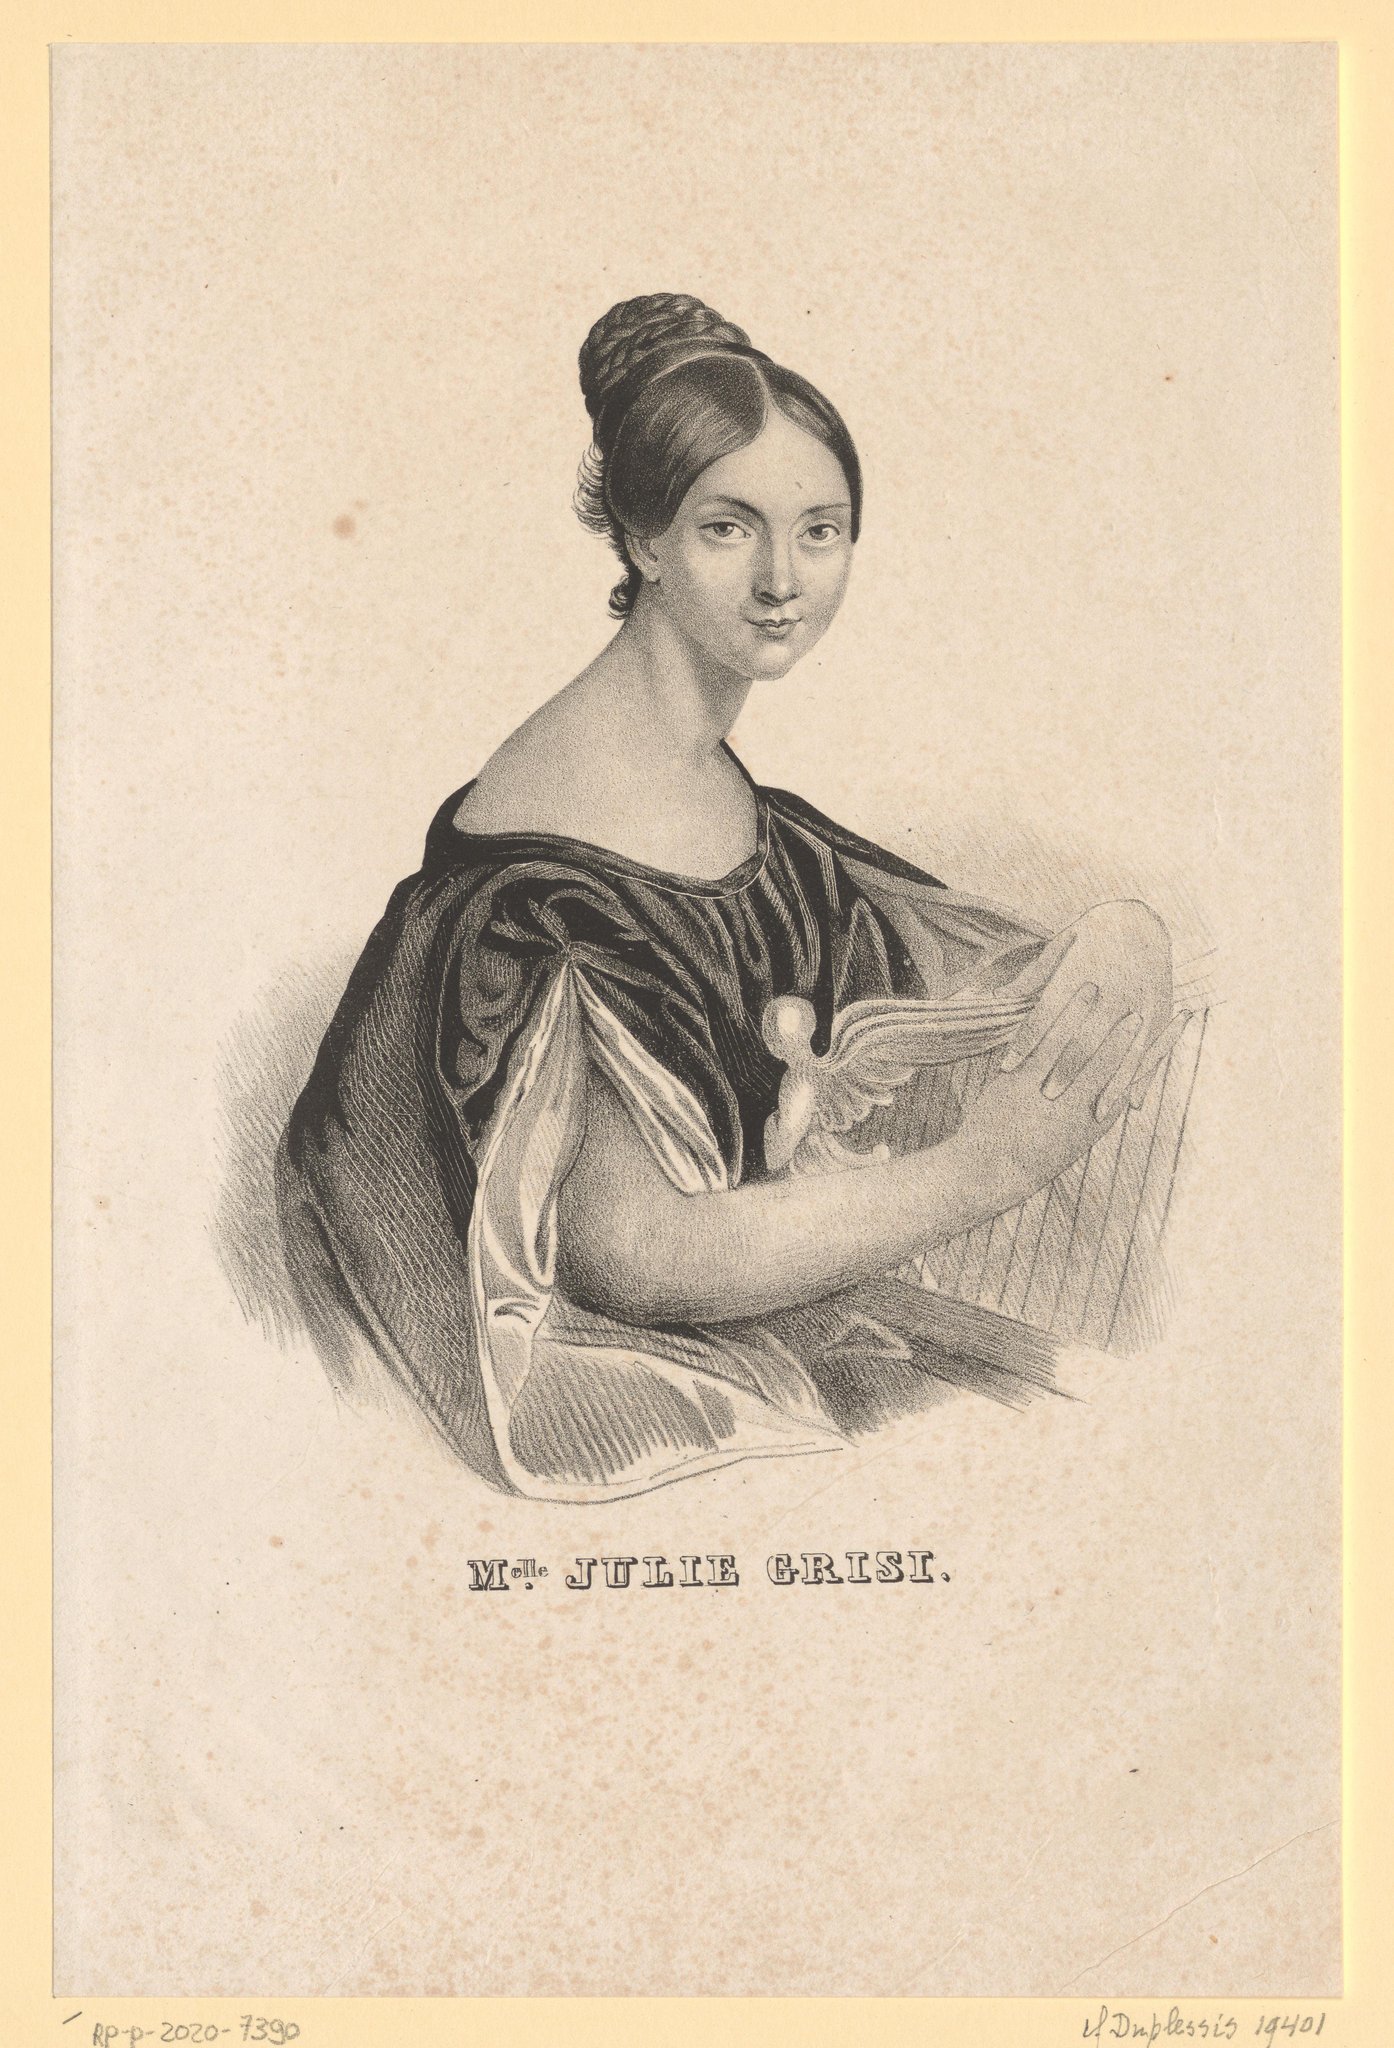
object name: print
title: Portret van Giulia Grisi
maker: Anonymous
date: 1821-1869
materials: paper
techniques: lithograph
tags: historical persons, string instruments (plucked), portrait of opera-singer